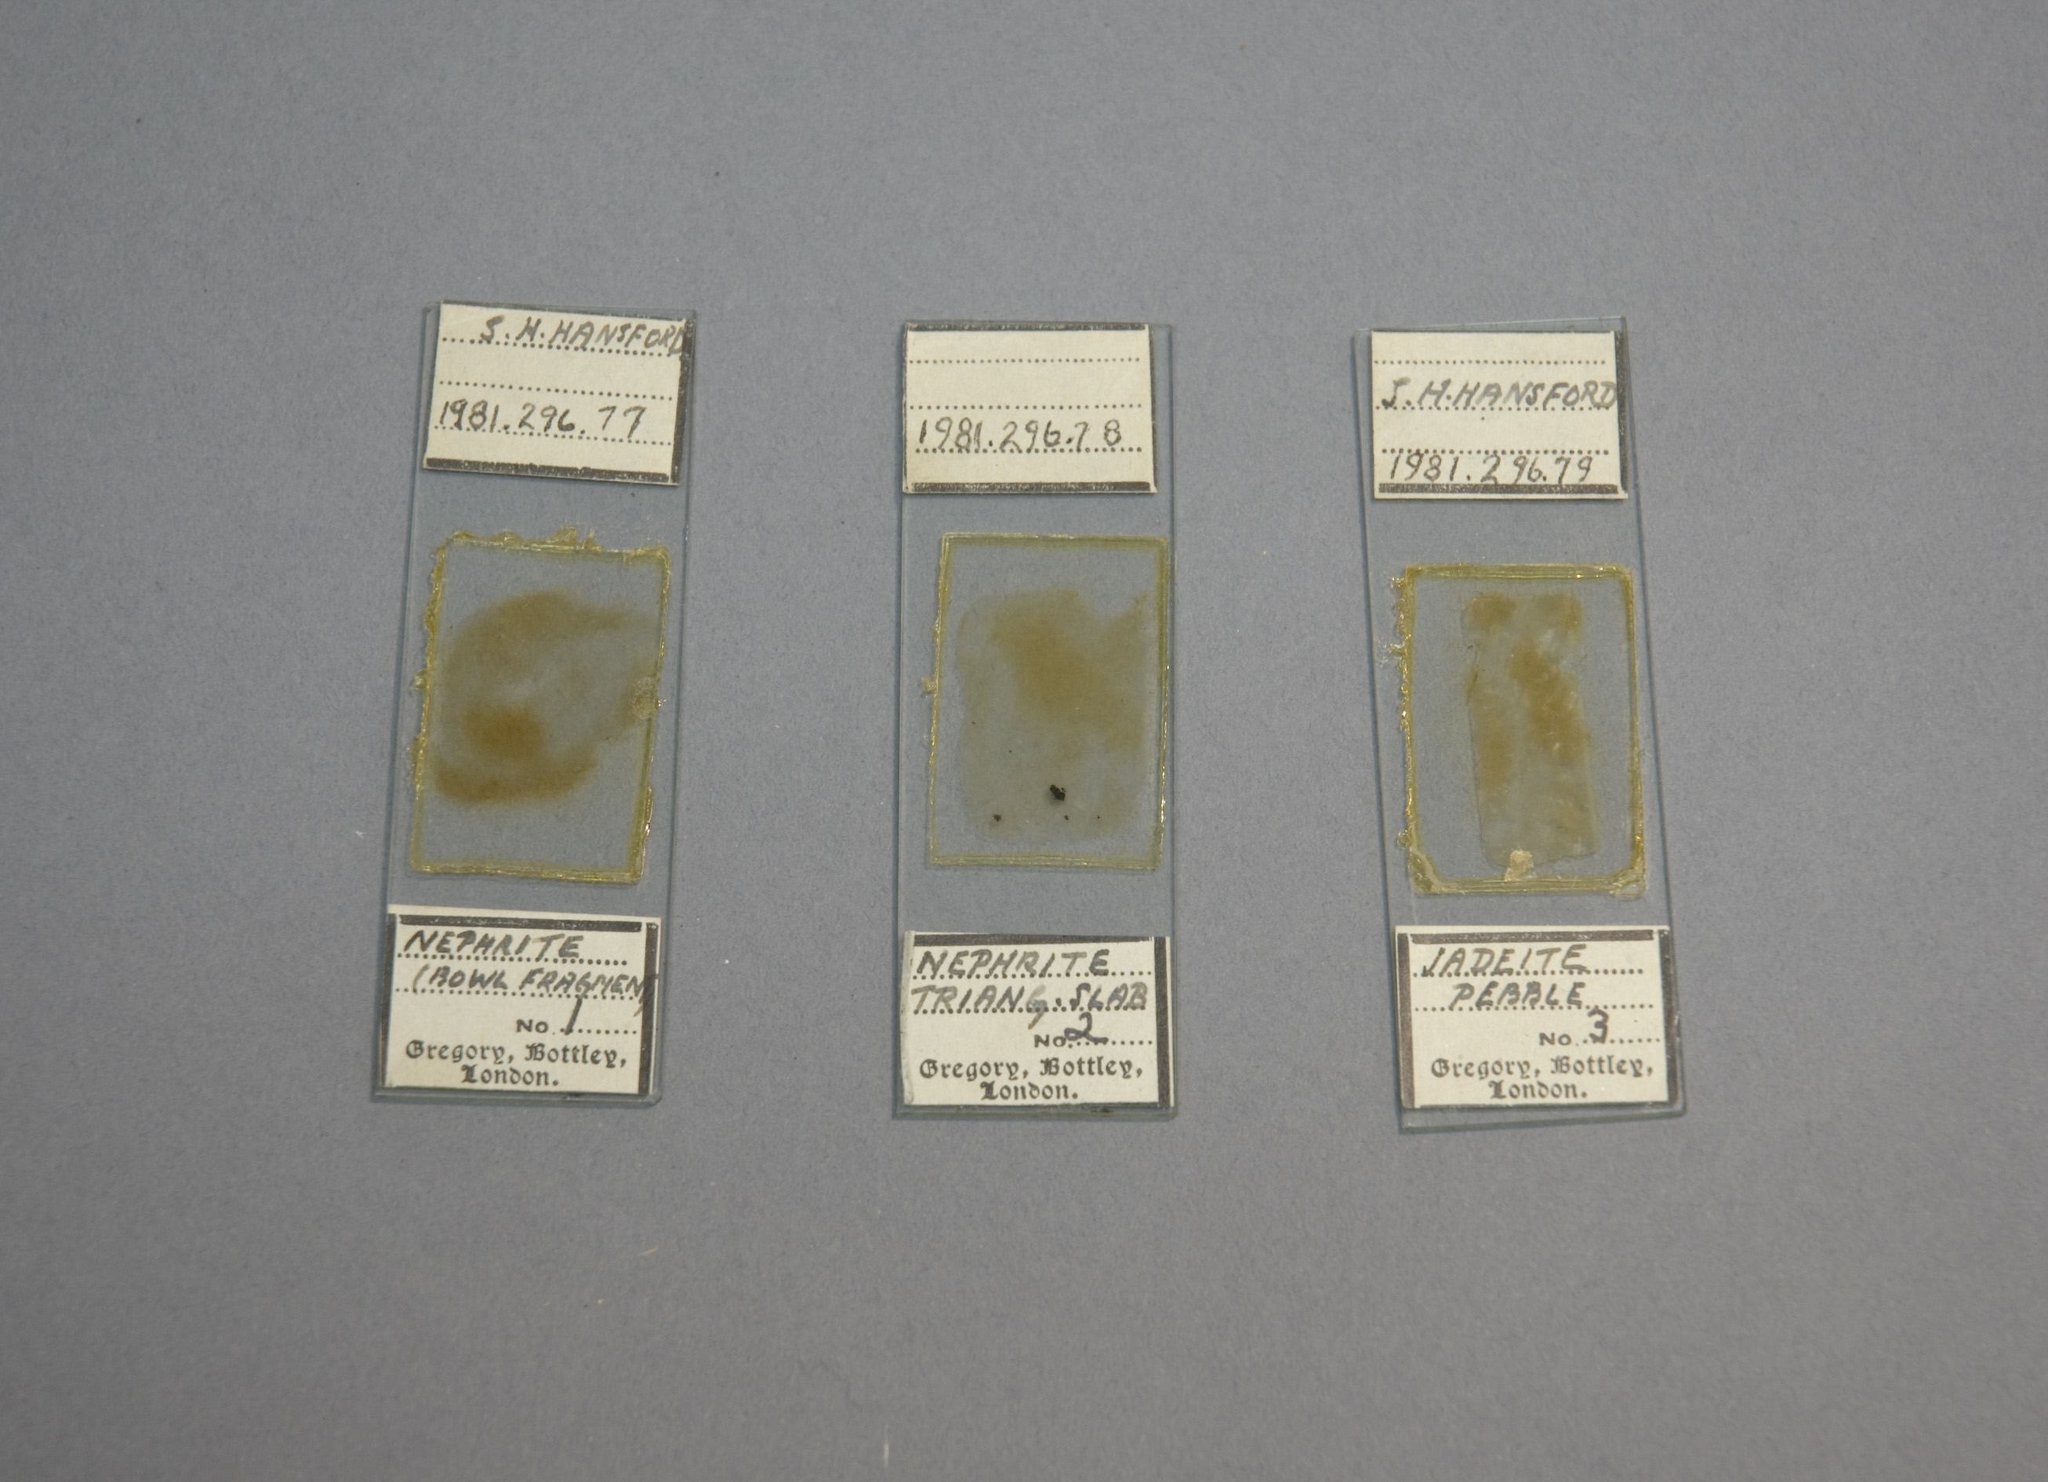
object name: jade carving material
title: Section of Nephrite Mounted in a Microscope Slide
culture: chinese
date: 1901-2000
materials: jade